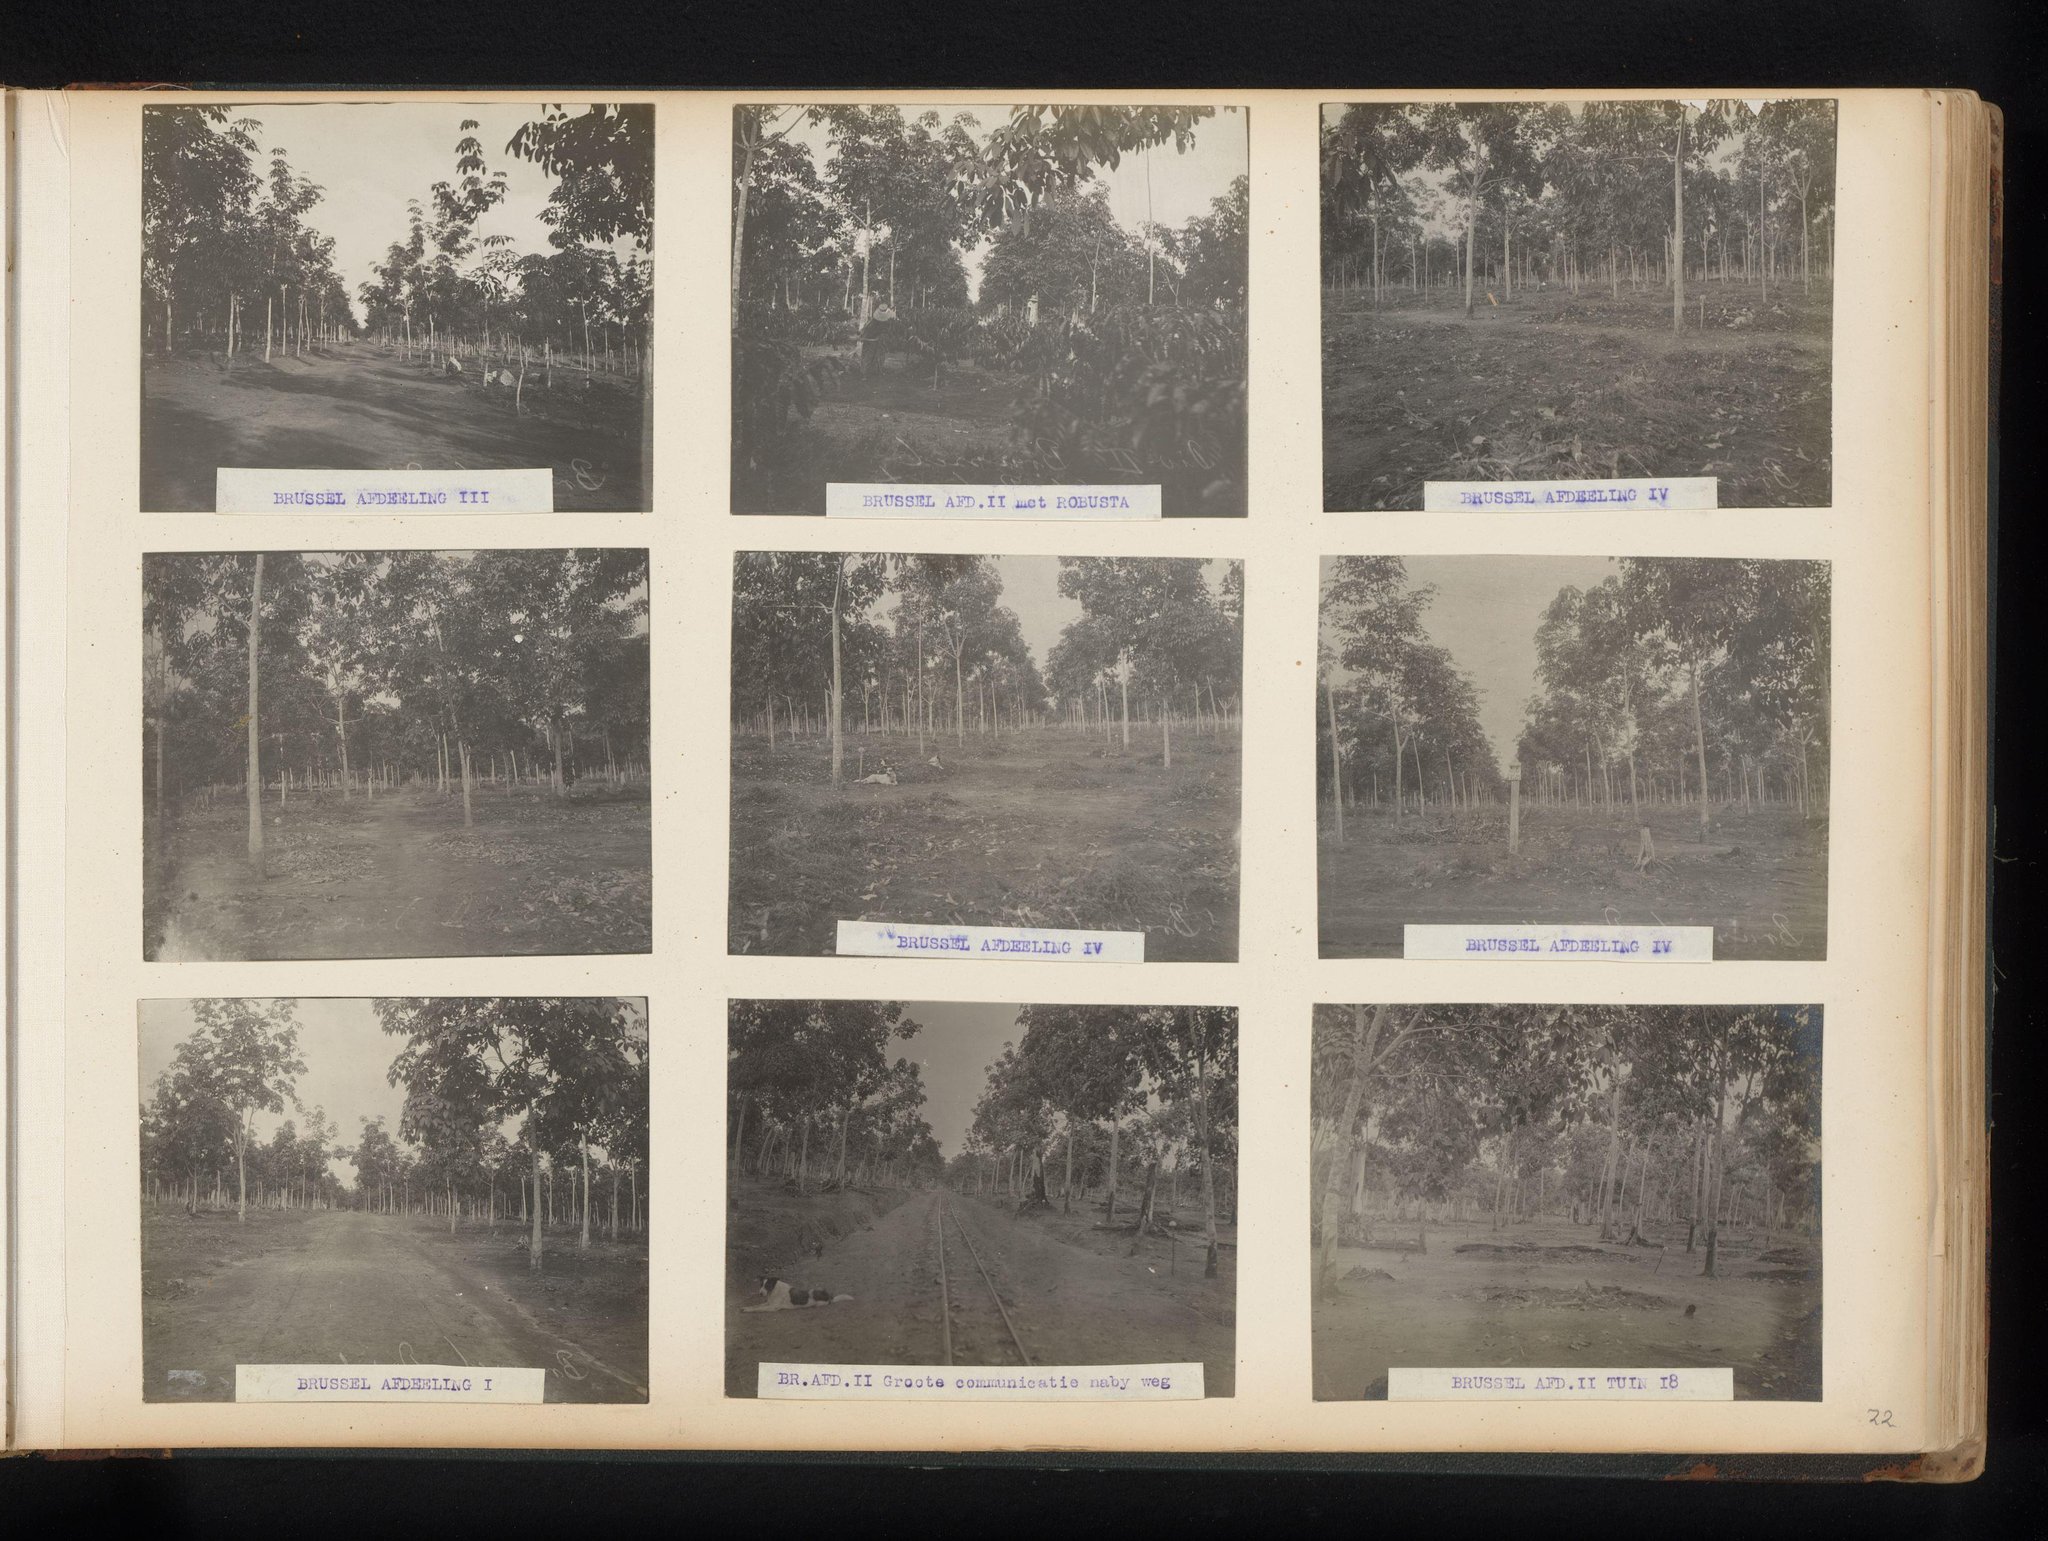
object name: photograph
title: Rubberbomen op Brussel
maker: Anonymous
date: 1913-1915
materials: cardboard, photographic support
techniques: gelatin silver print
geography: east sumatra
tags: plantation, (non-fruit) products of plants or trees: rubber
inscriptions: inscription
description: Blad met negen foto's van rubberbomen op plantage Brussel. Onder de foto's etiketten met onderschriften. Onderdeel van het fotoalbum over de plantages Brussel en Pernantian van de Sumatra Caoutchouc Maatschappij op de Oostkust van Sumatra in de jaren 1910-1935.